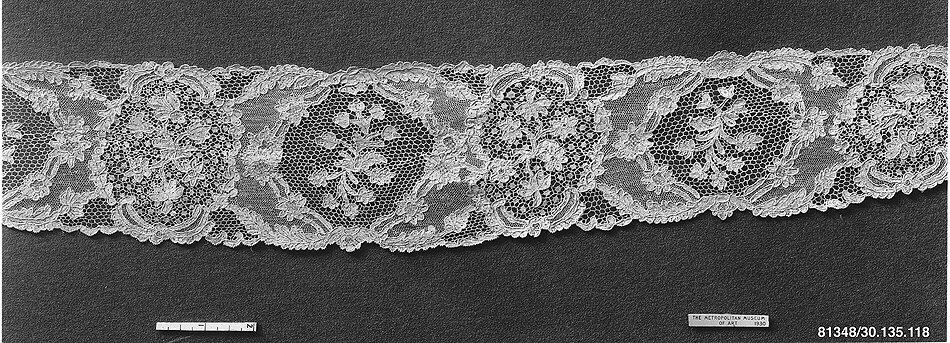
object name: cravat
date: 1701-1800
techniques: lace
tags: flowers